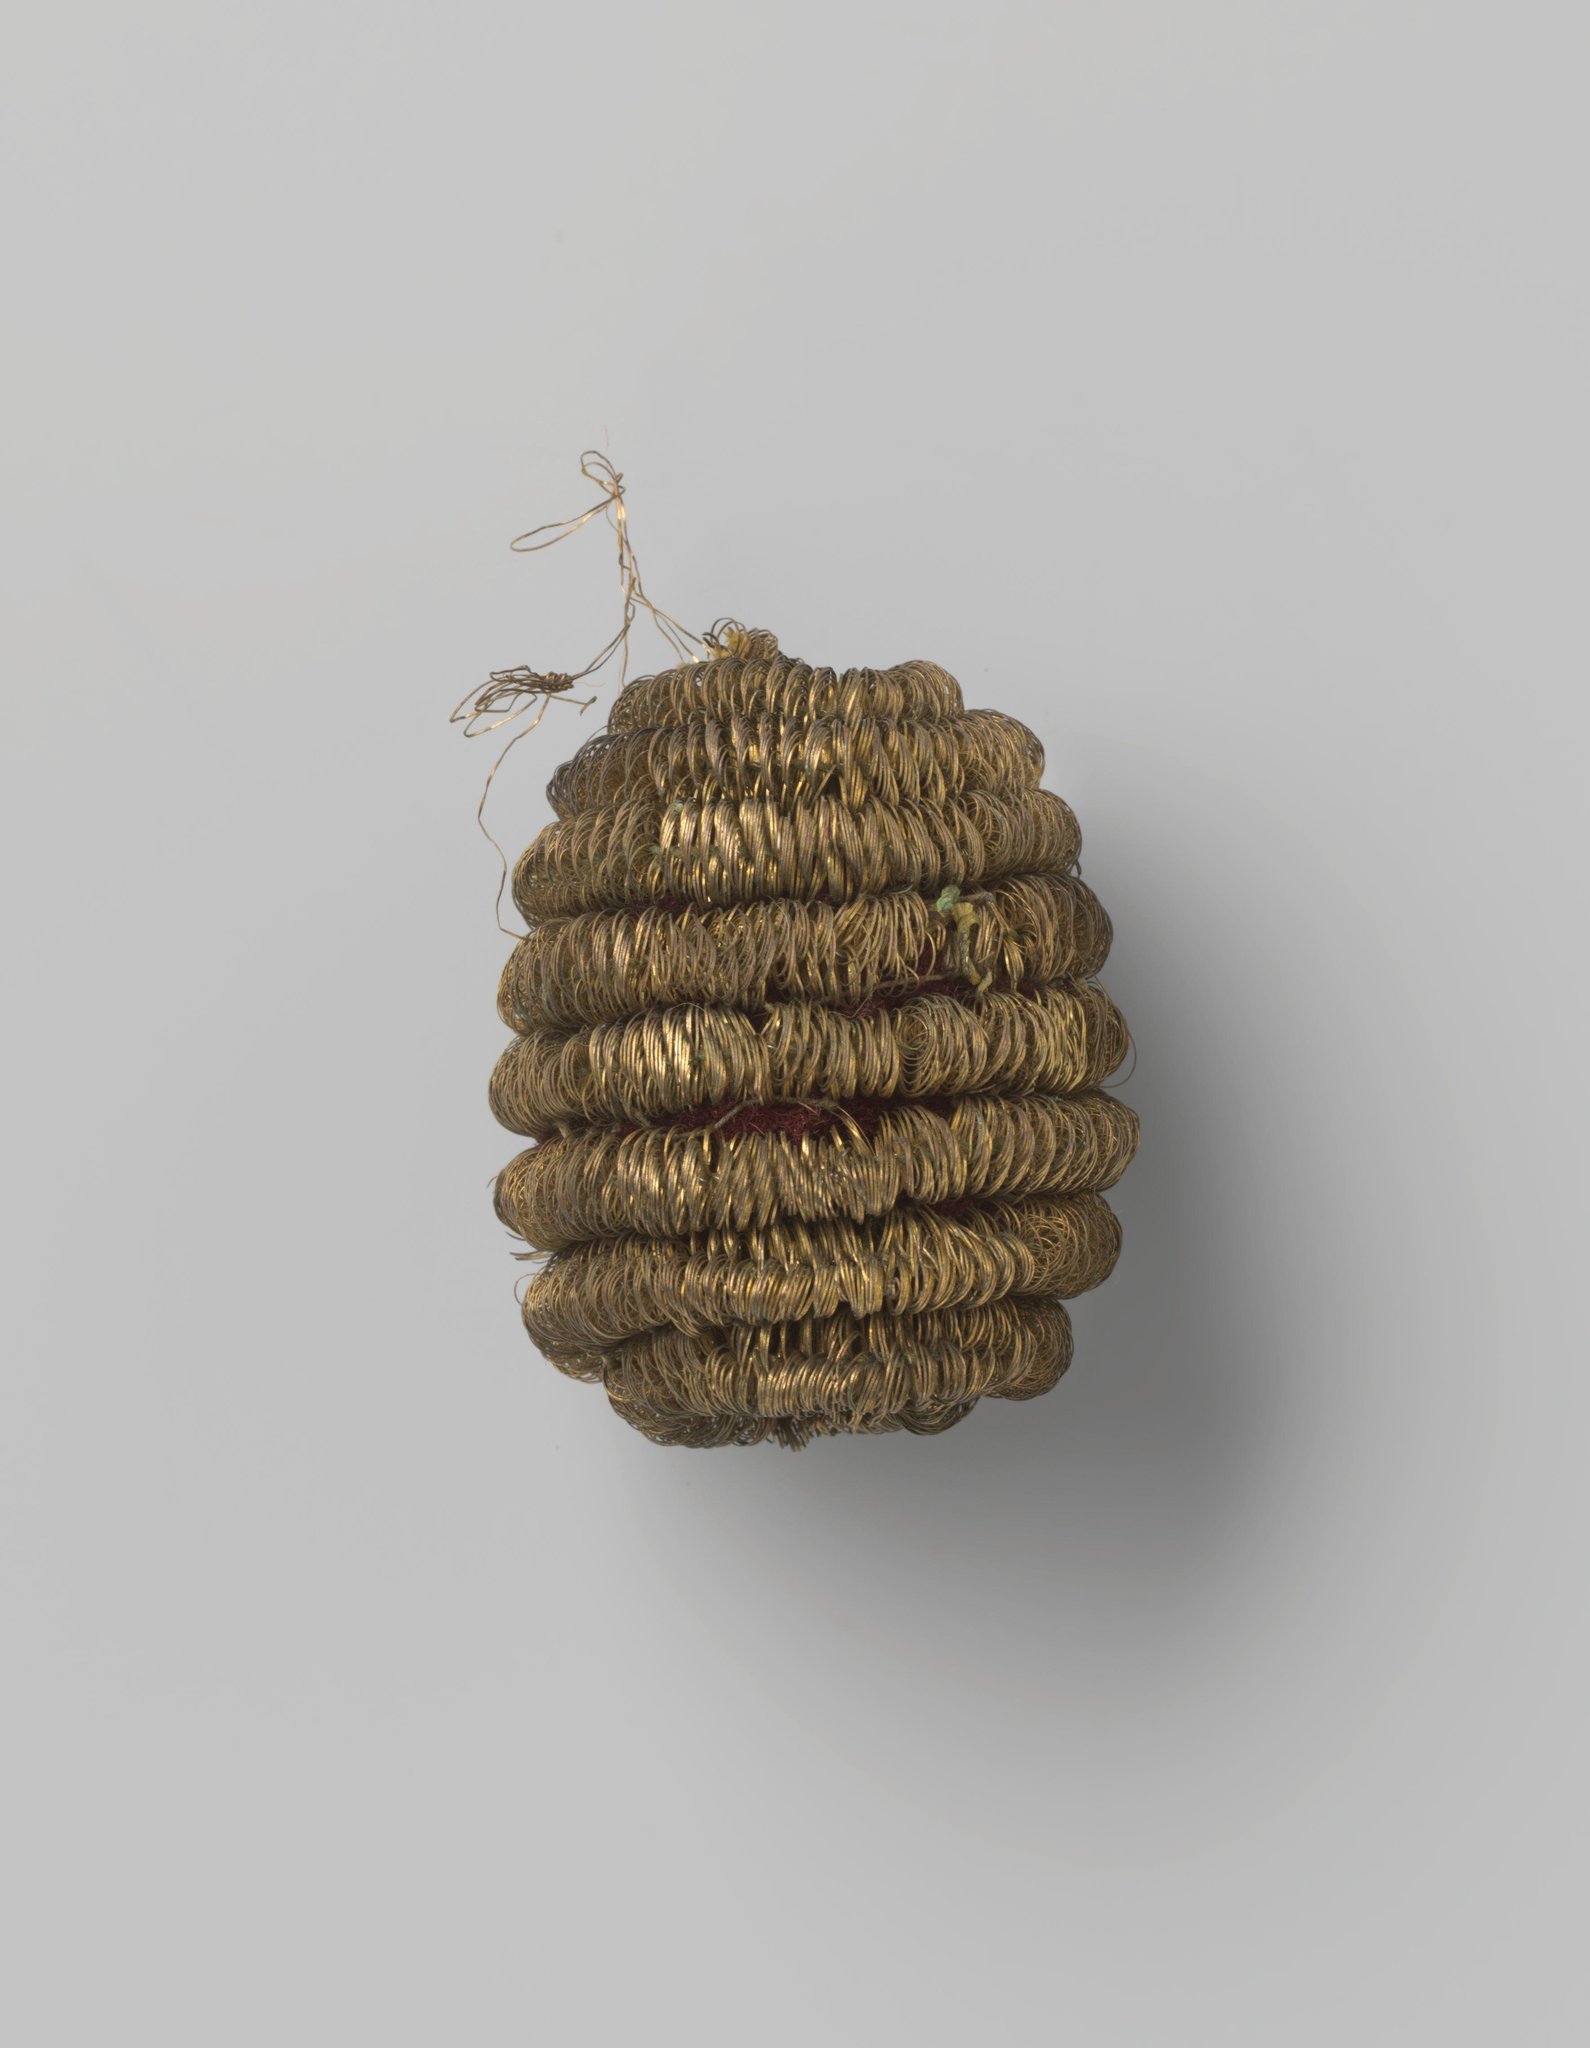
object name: pompon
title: Pompon, ovaal, vermoedelijk van een sjako van een hoofdofficier van het Nederlandse leger, ca. 1815-1820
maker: Anonymous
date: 1815-1820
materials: gold thread, wool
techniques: stitching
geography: netherlands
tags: netherlands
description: Hoofddeksel, ovaal, onderdeel van gedraaid gouddraad. Gezet op een rode wollen kern.